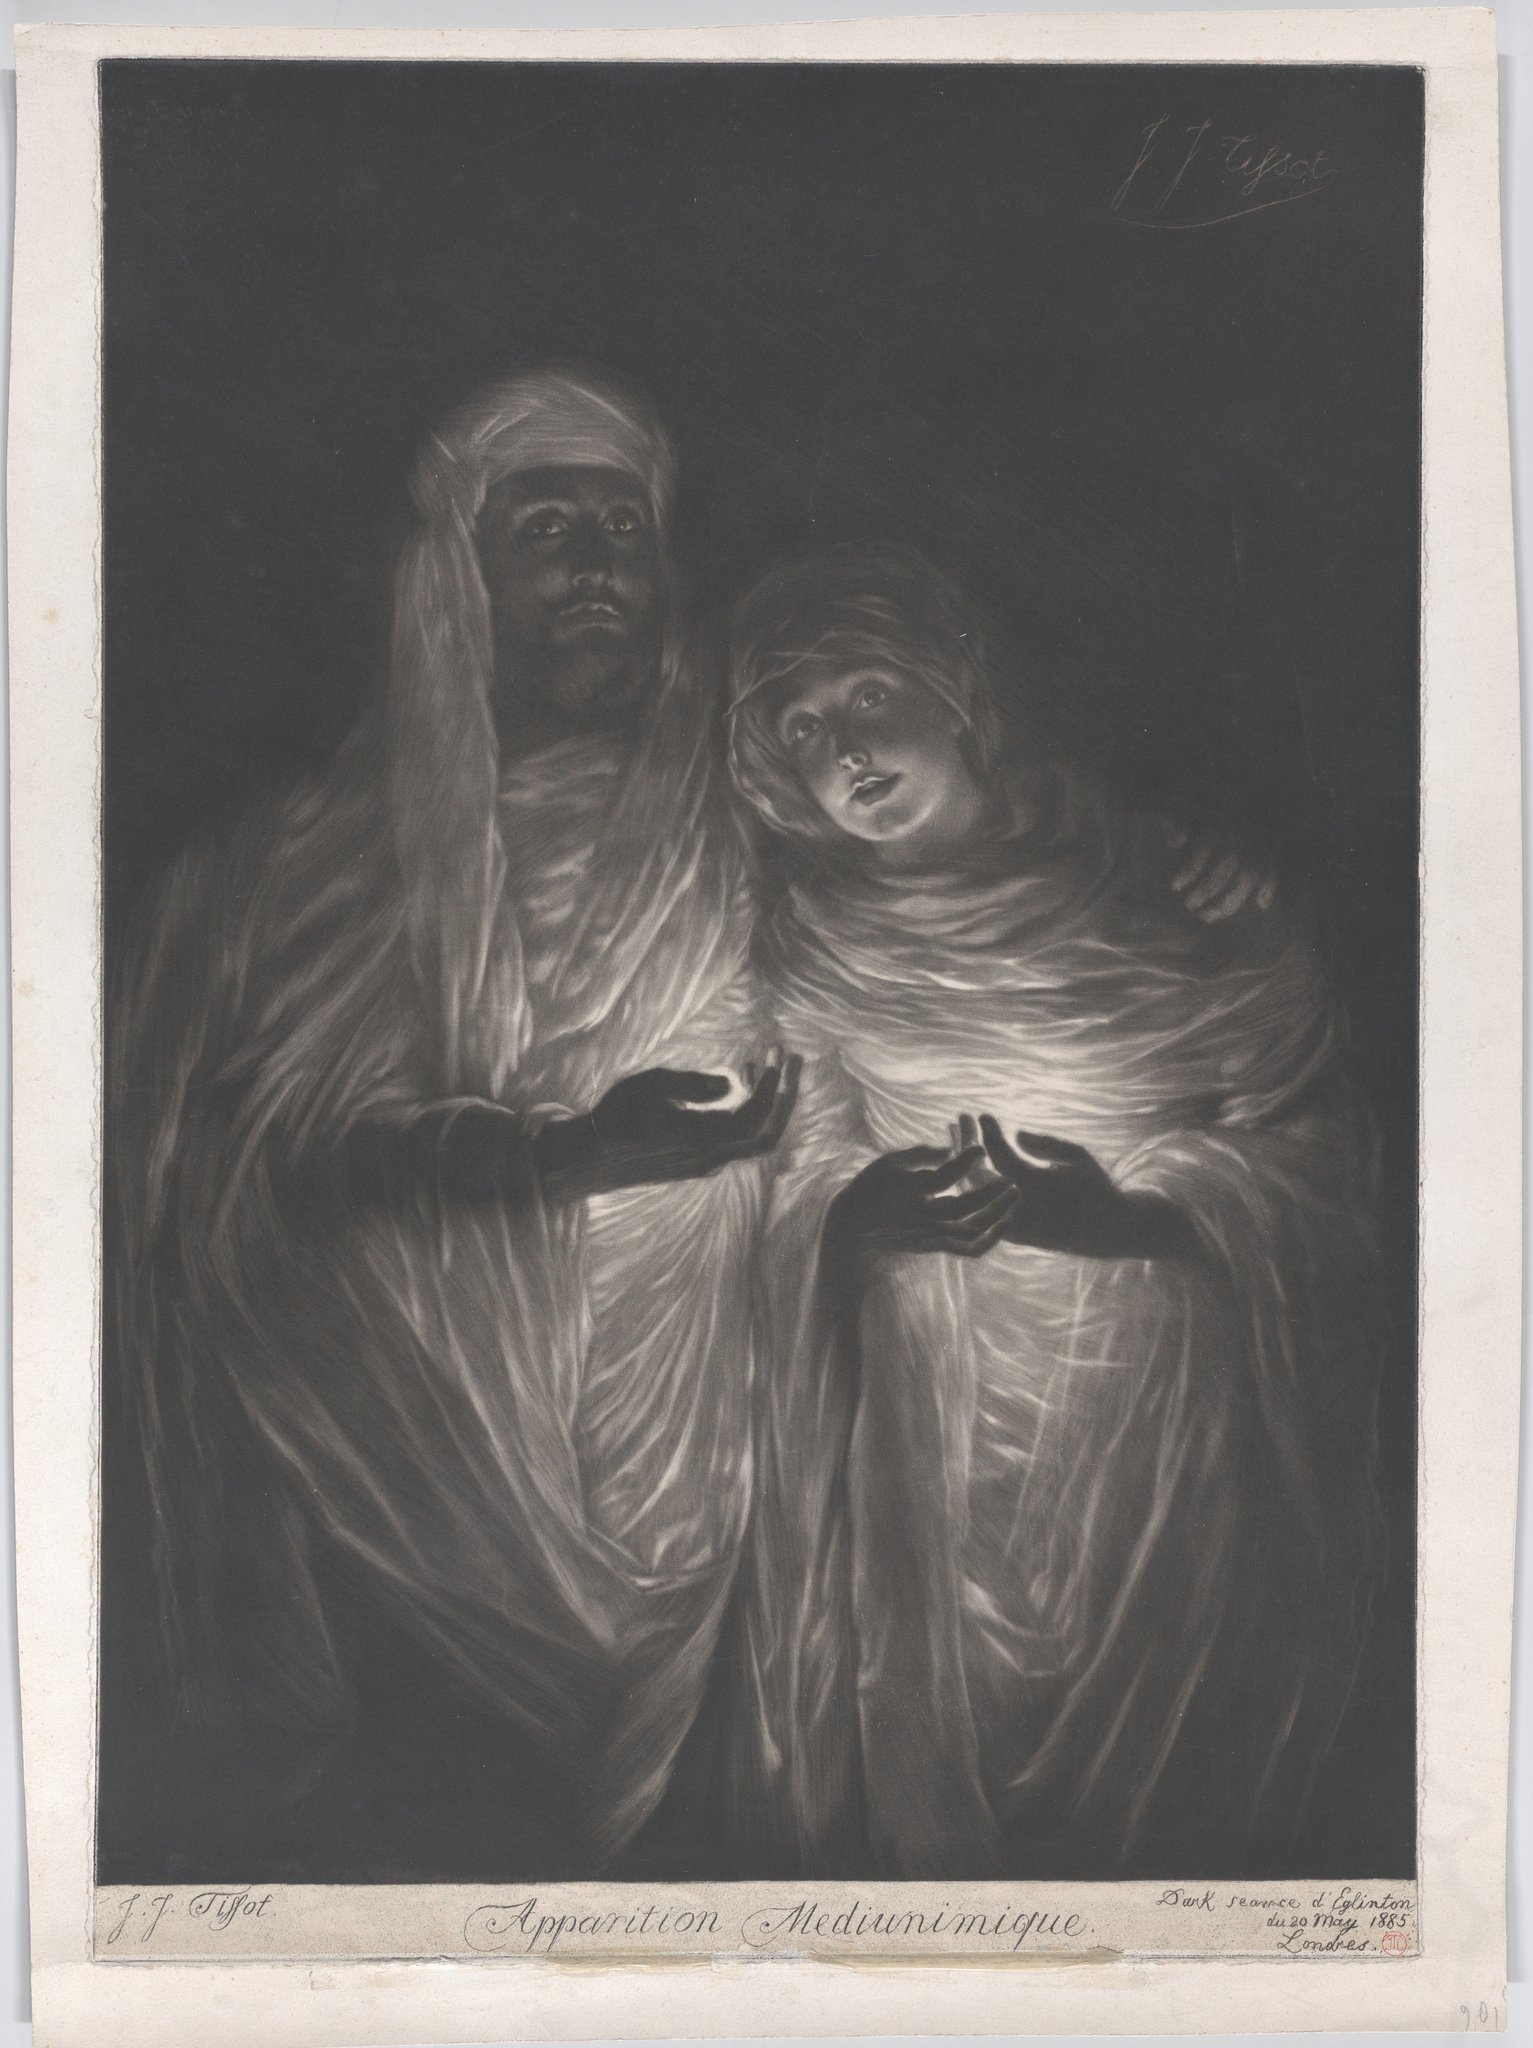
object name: print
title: The Apparition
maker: james tissot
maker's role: artist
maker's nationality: french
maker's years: 1836-1902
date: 1885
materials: paper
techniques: mezzotint